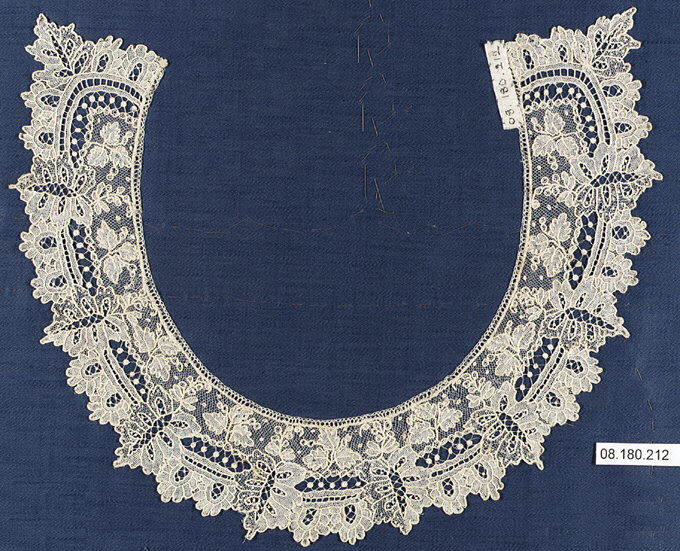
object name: barbe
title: Barbe (one end)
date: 1801-1900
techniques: lace